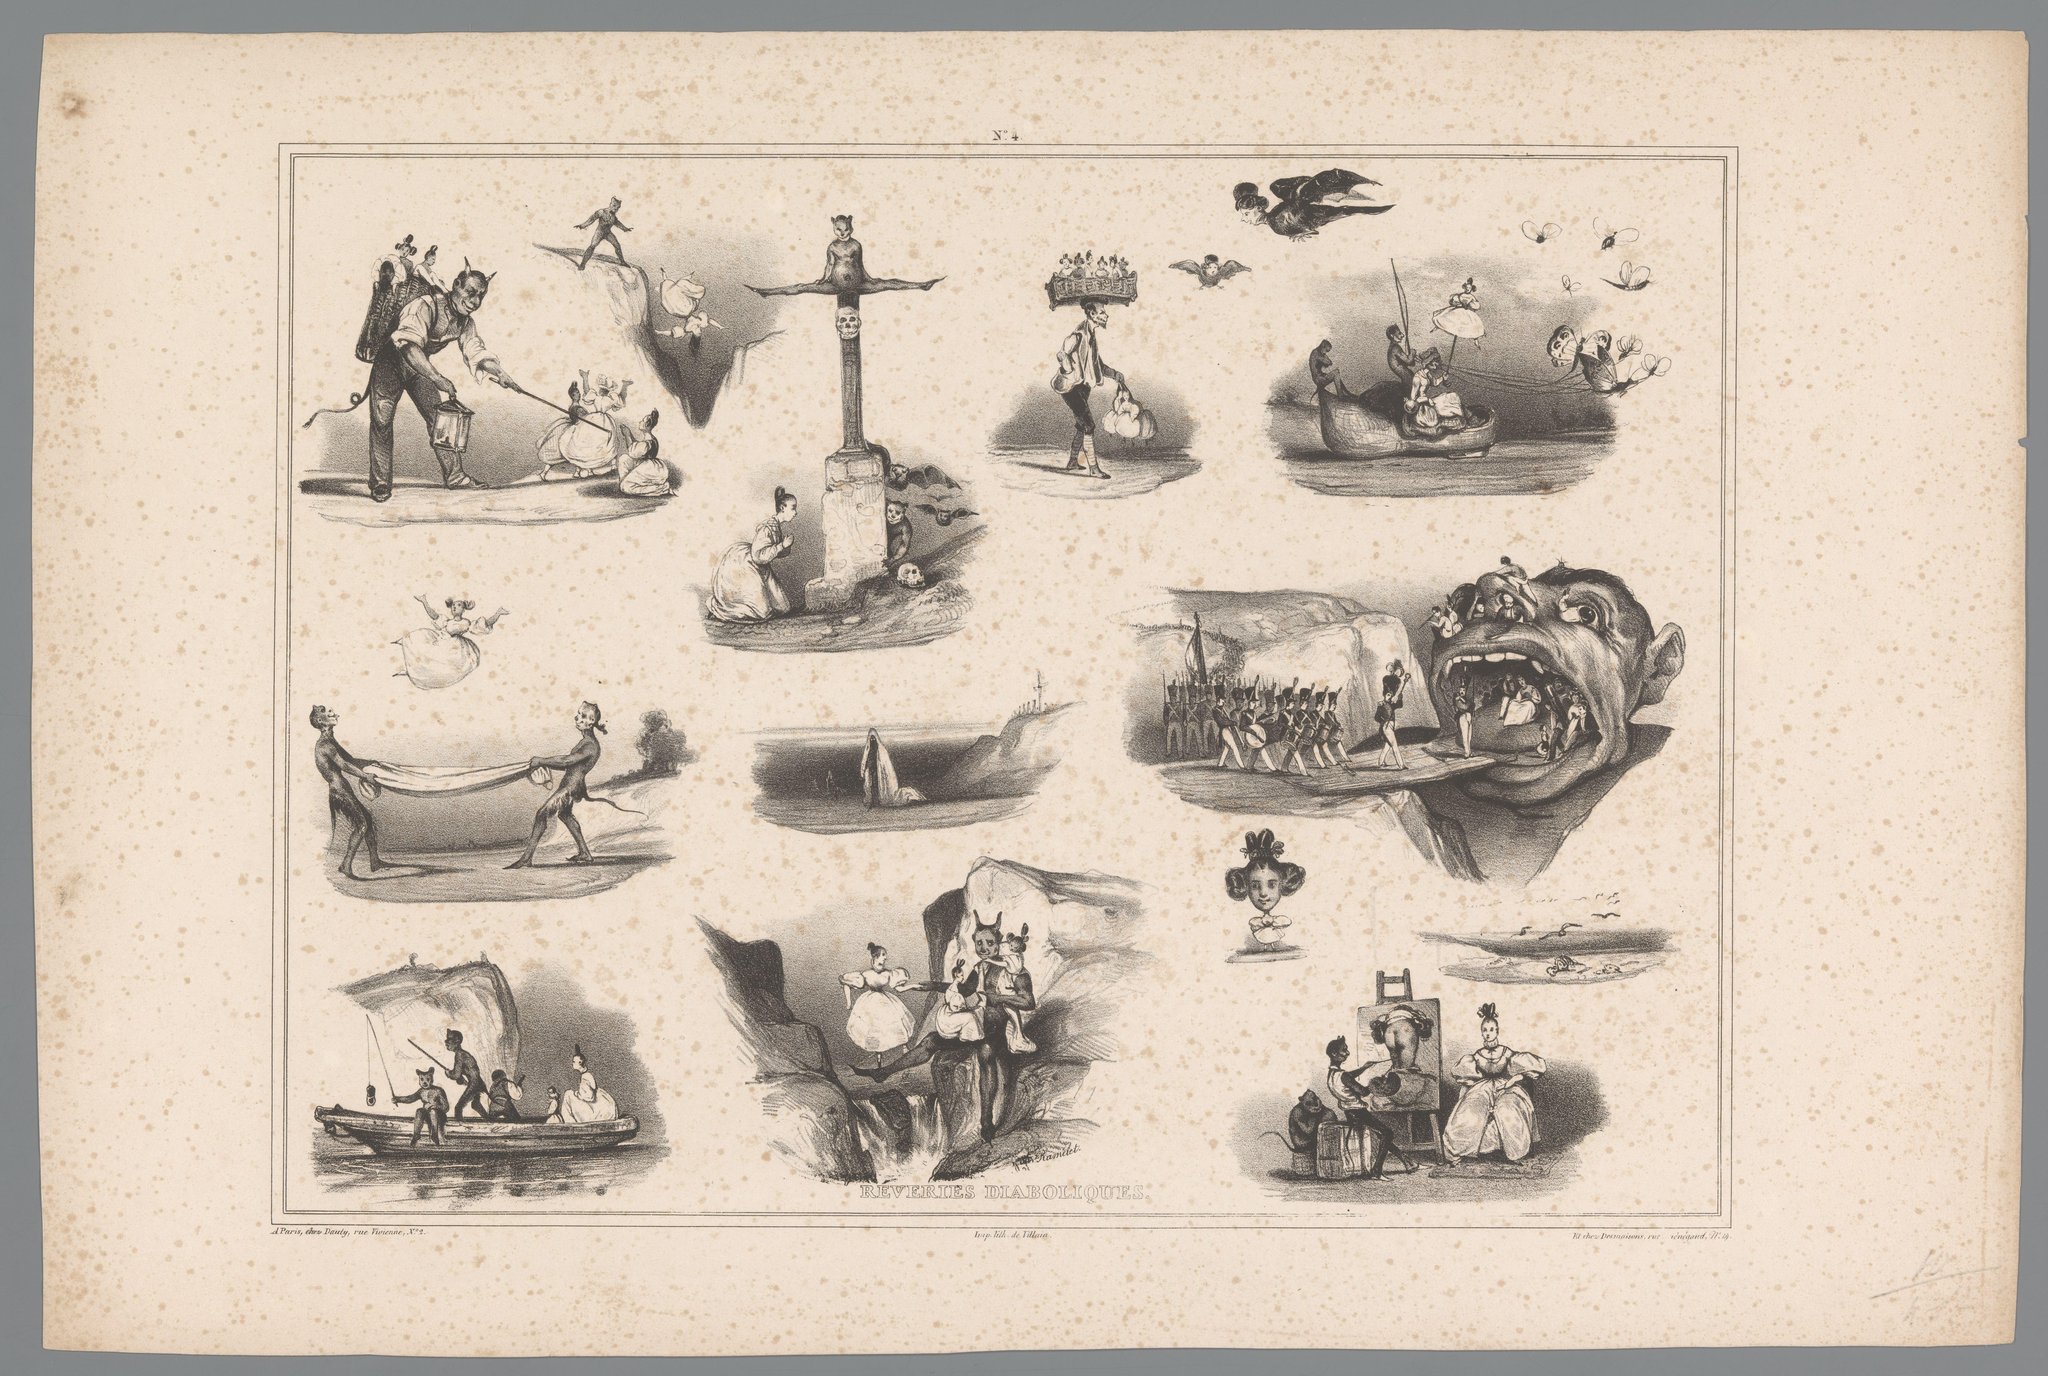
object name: print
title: Duivelse dromen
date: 1832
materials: paper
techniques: lithograph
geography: paris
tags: adult woman, activities of devil(s)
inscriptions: collector's mark: Lugt 2228